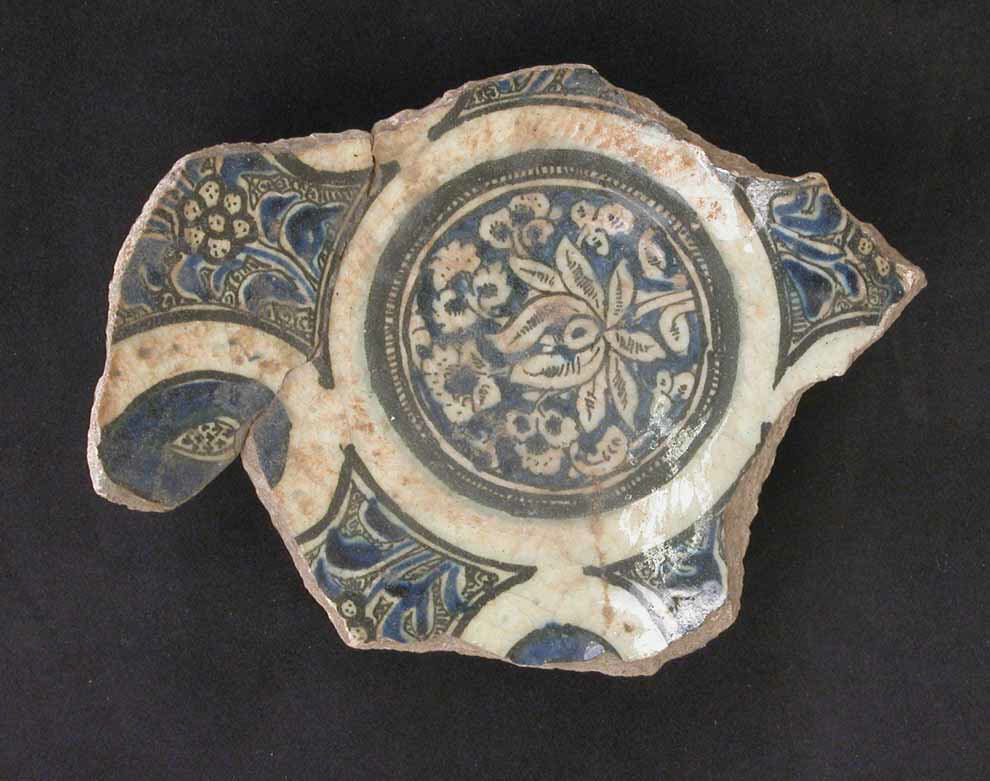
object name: fragment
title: Fragment of a Bowl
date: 1301-1400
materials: glaze, stonepaste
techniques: painting, polychrome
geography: syria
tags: flowers